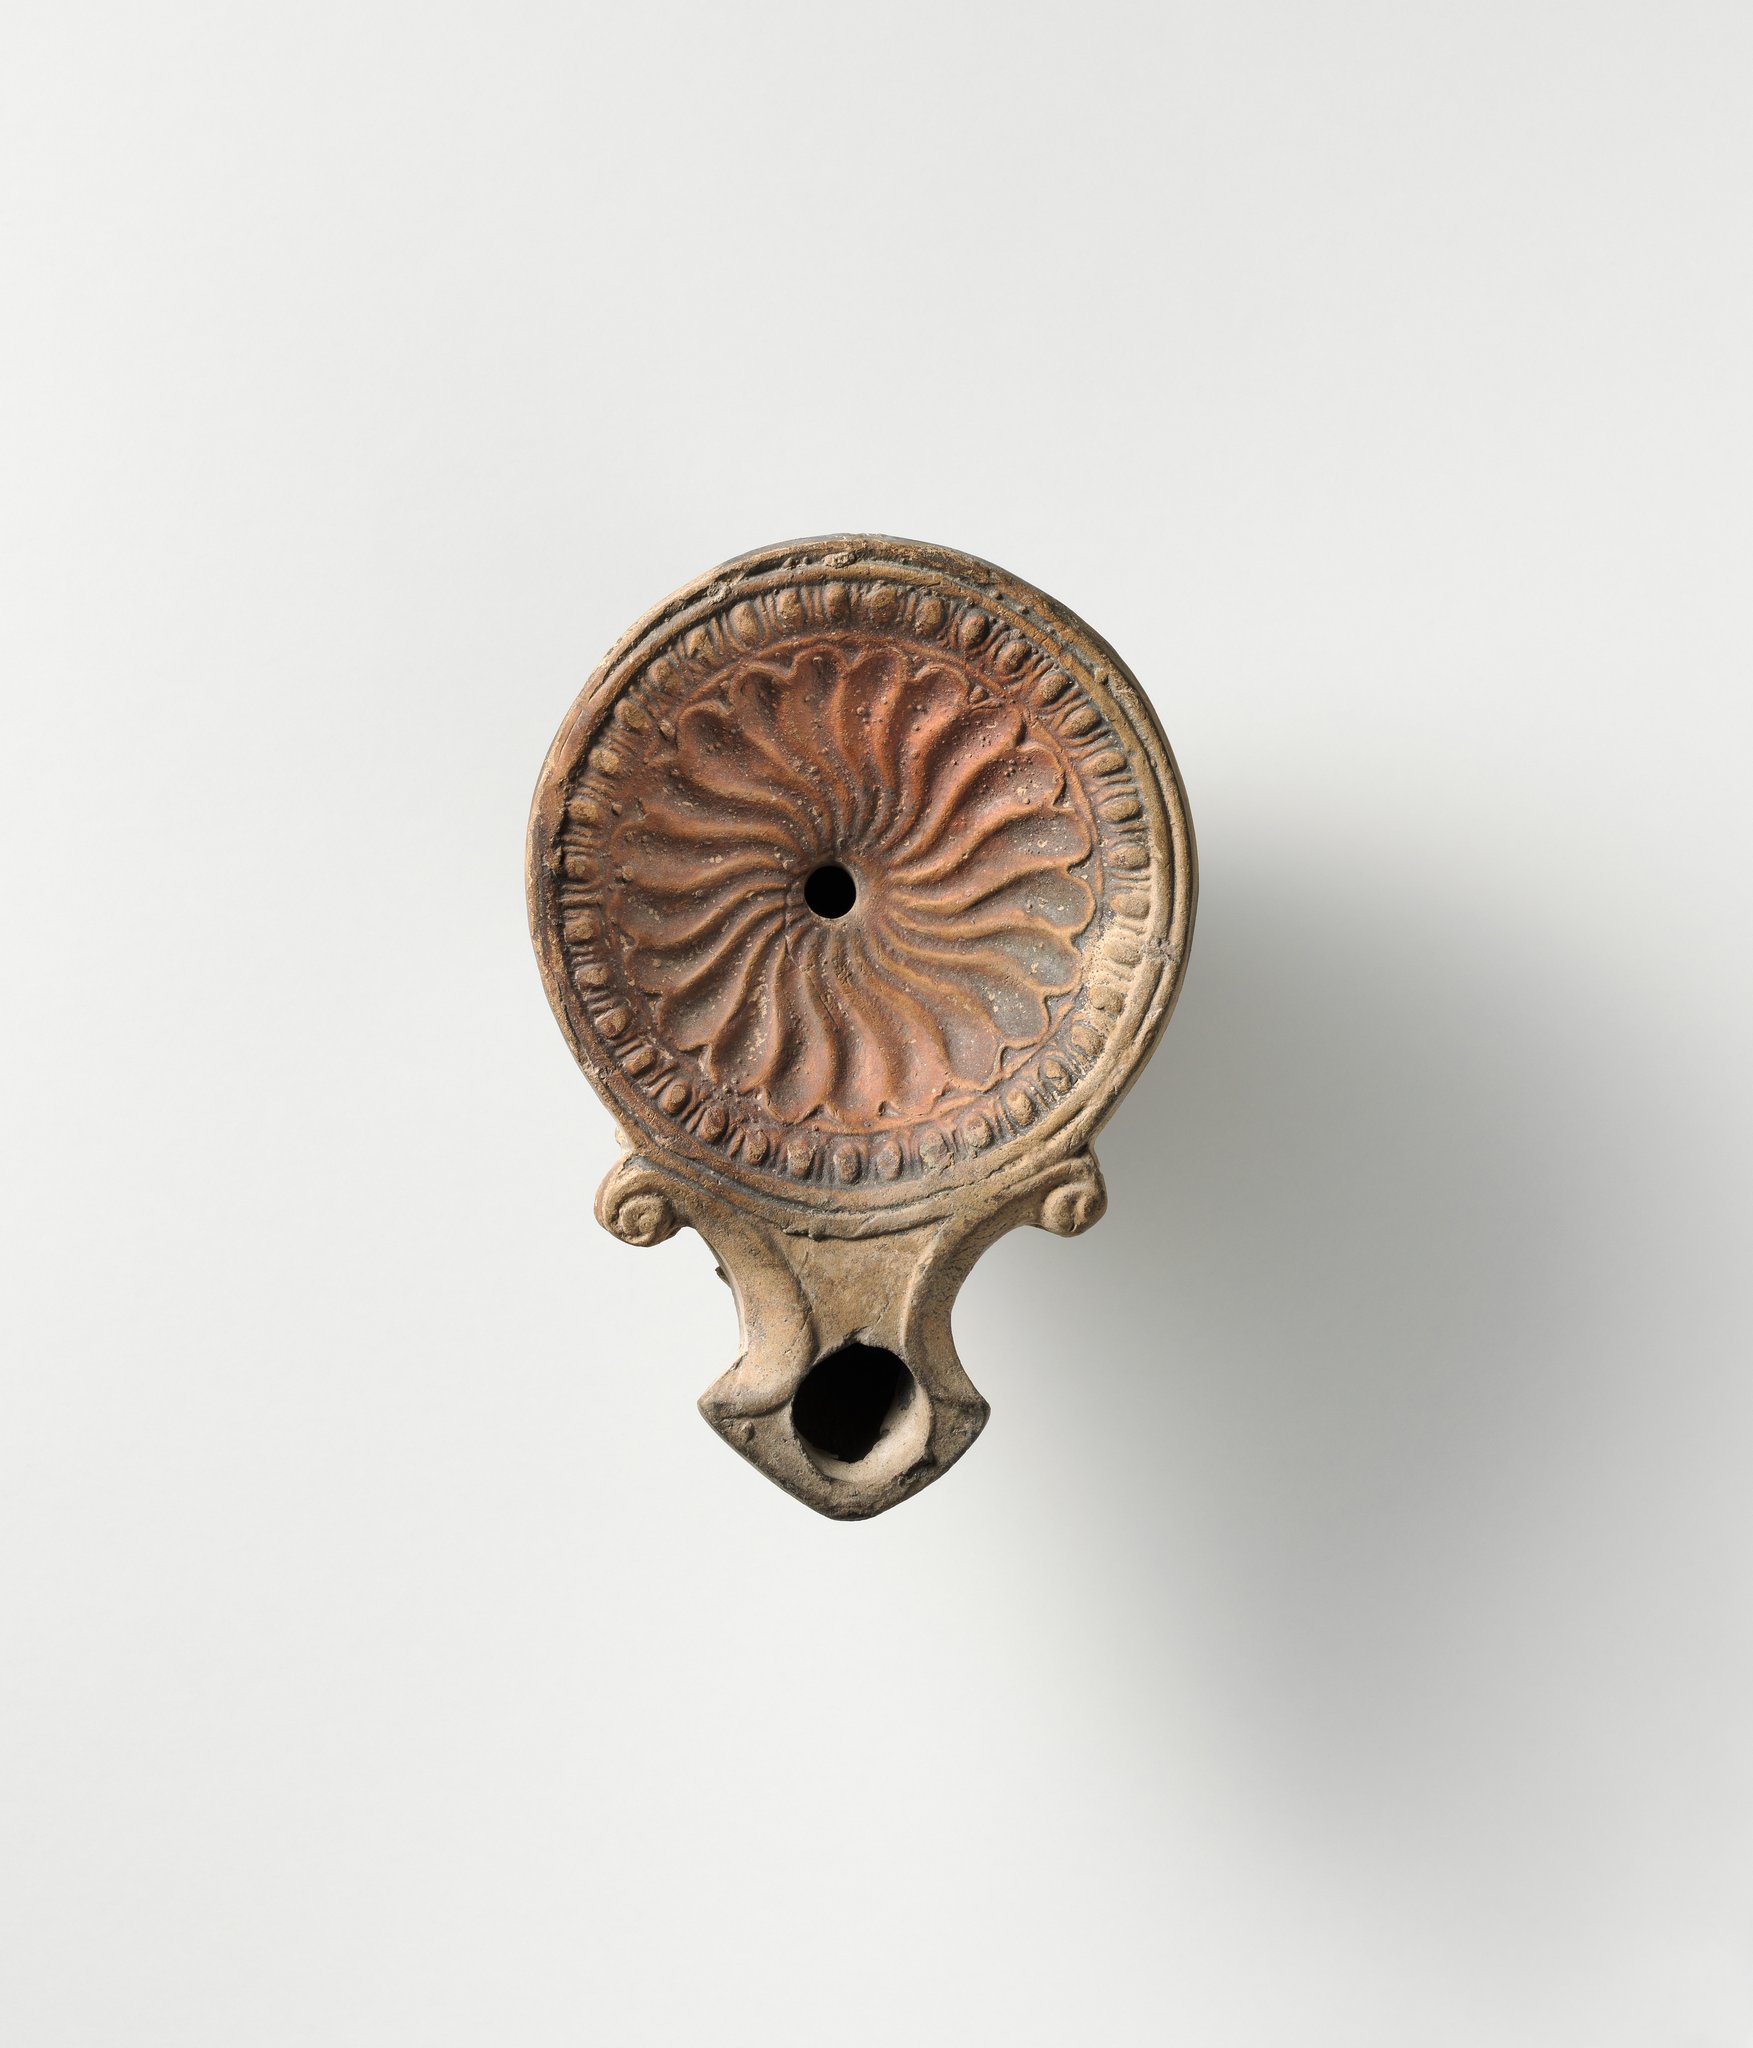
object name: lamp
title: Terracotta oil lamp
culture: roman, cypriot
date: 267-300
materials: terracotta